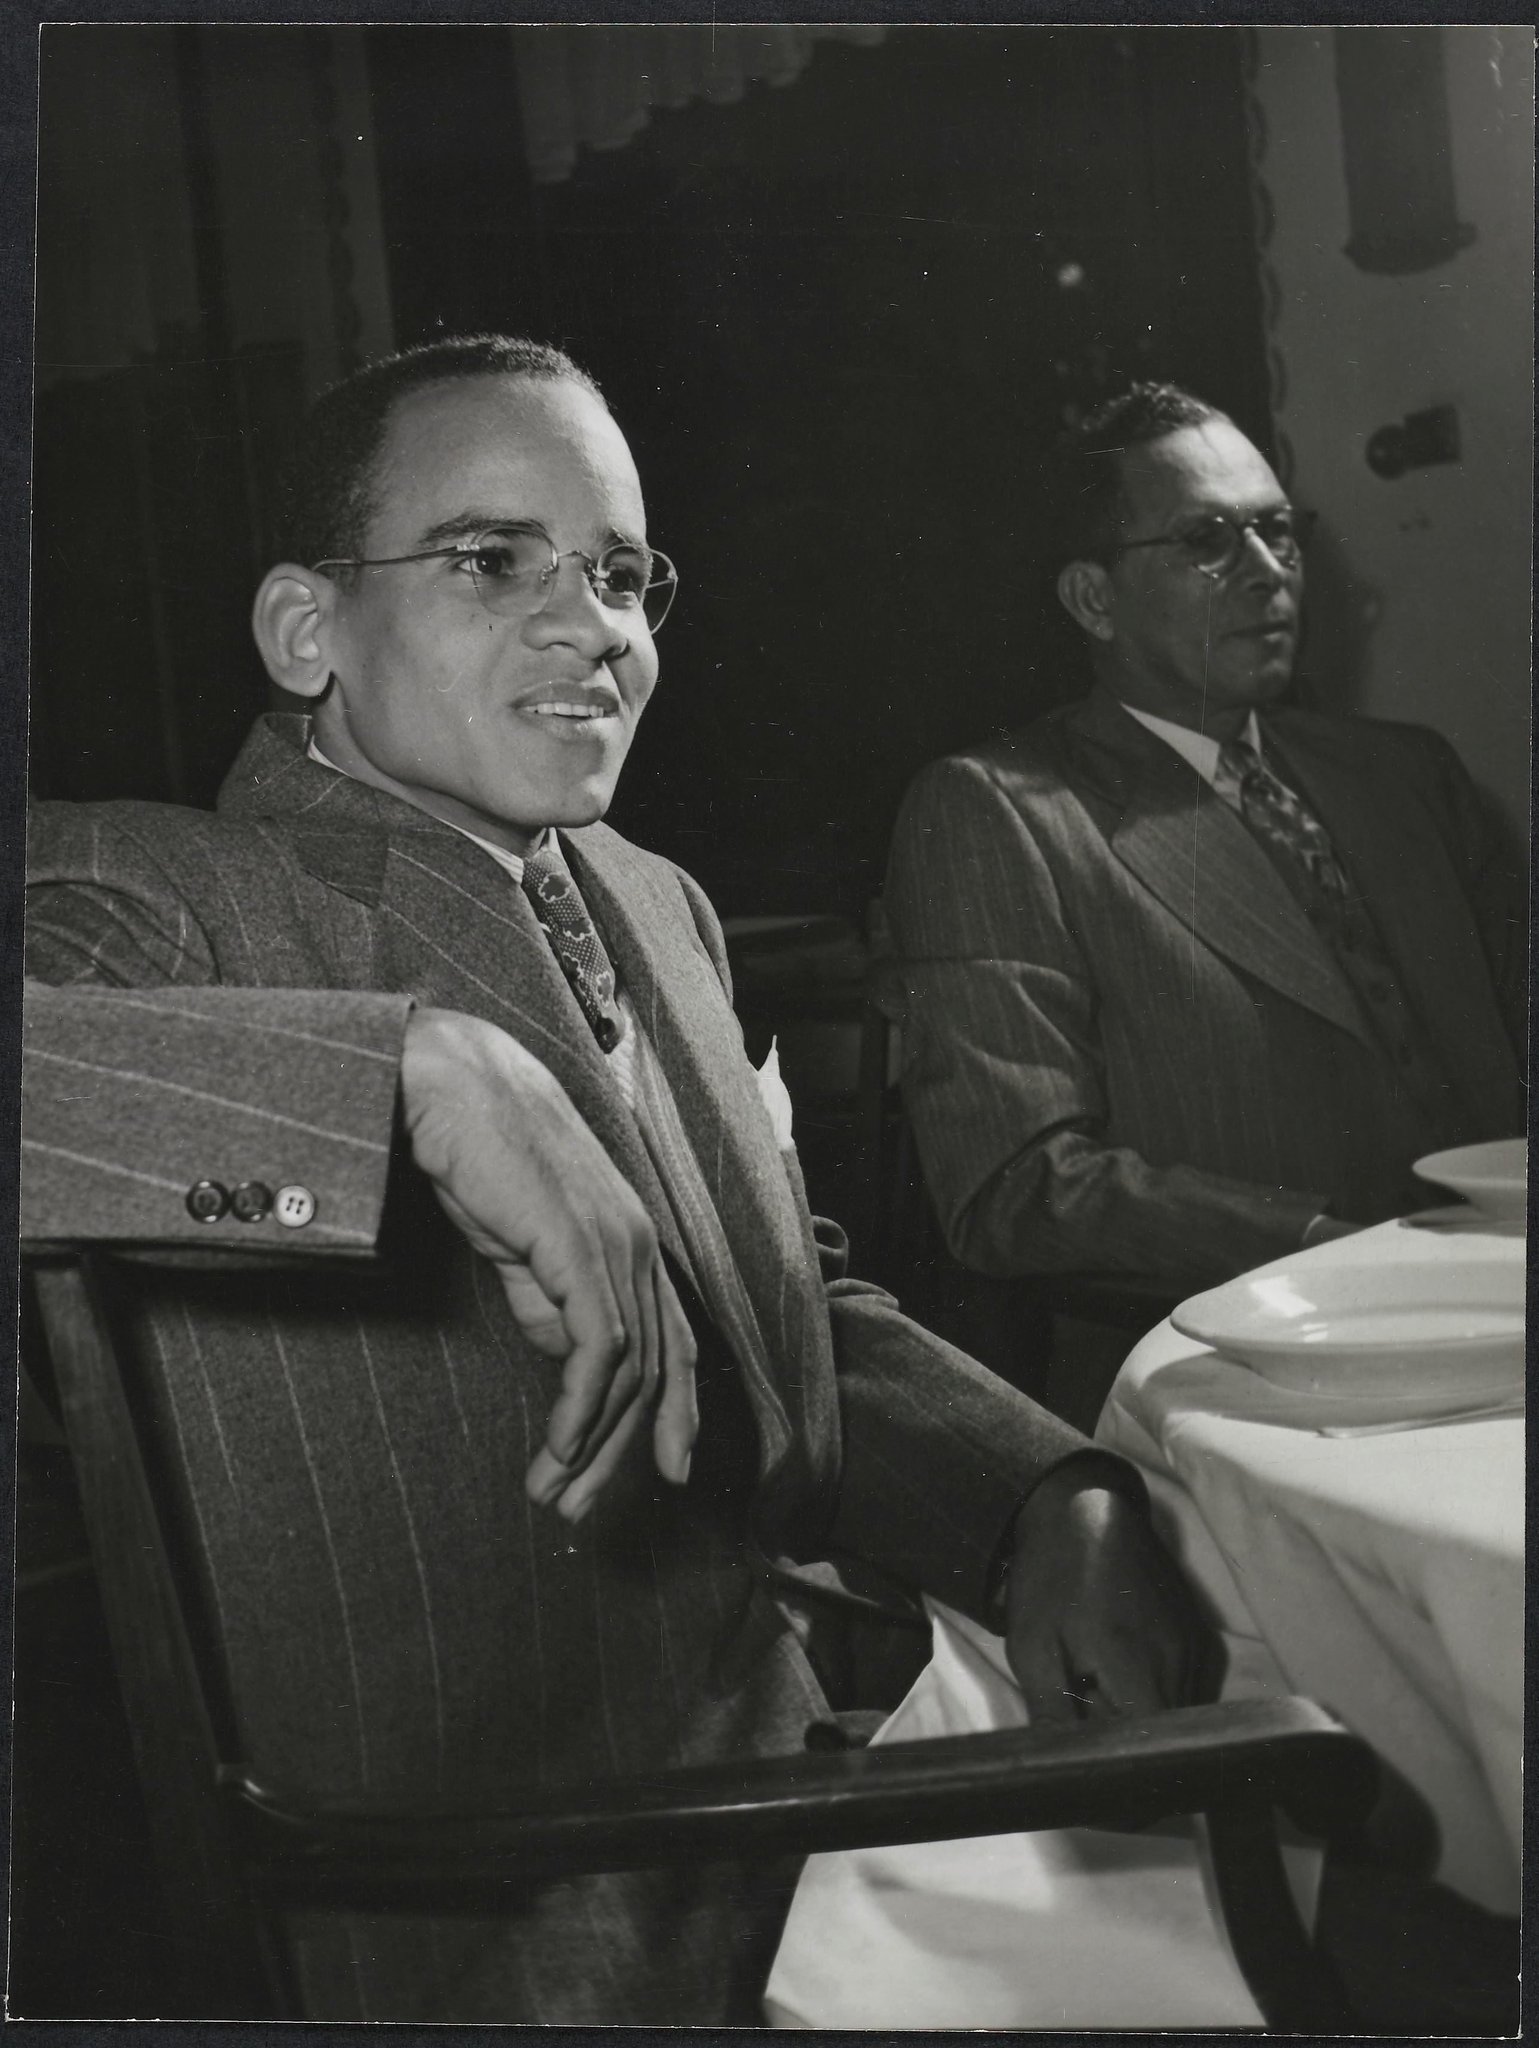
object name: documentary photograph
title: Surinamers in Nederland: 29 foto's uit het archief van Ons Vrije Nederland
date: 1902-1948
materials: photographic support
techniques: photography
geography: the hague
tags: netherlands, suriname, the hague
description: Een van de journalisten die de Ronde Tafel Conferentie tussen Nederland en de West bijwoonden: de heer L. P. Daal vertegenwoordigt het Spaanstalige blad "La Prensa" dat op Curaçao verschijnt. Hij zit aan een gedekte tafel met achter hem nog een persoon.